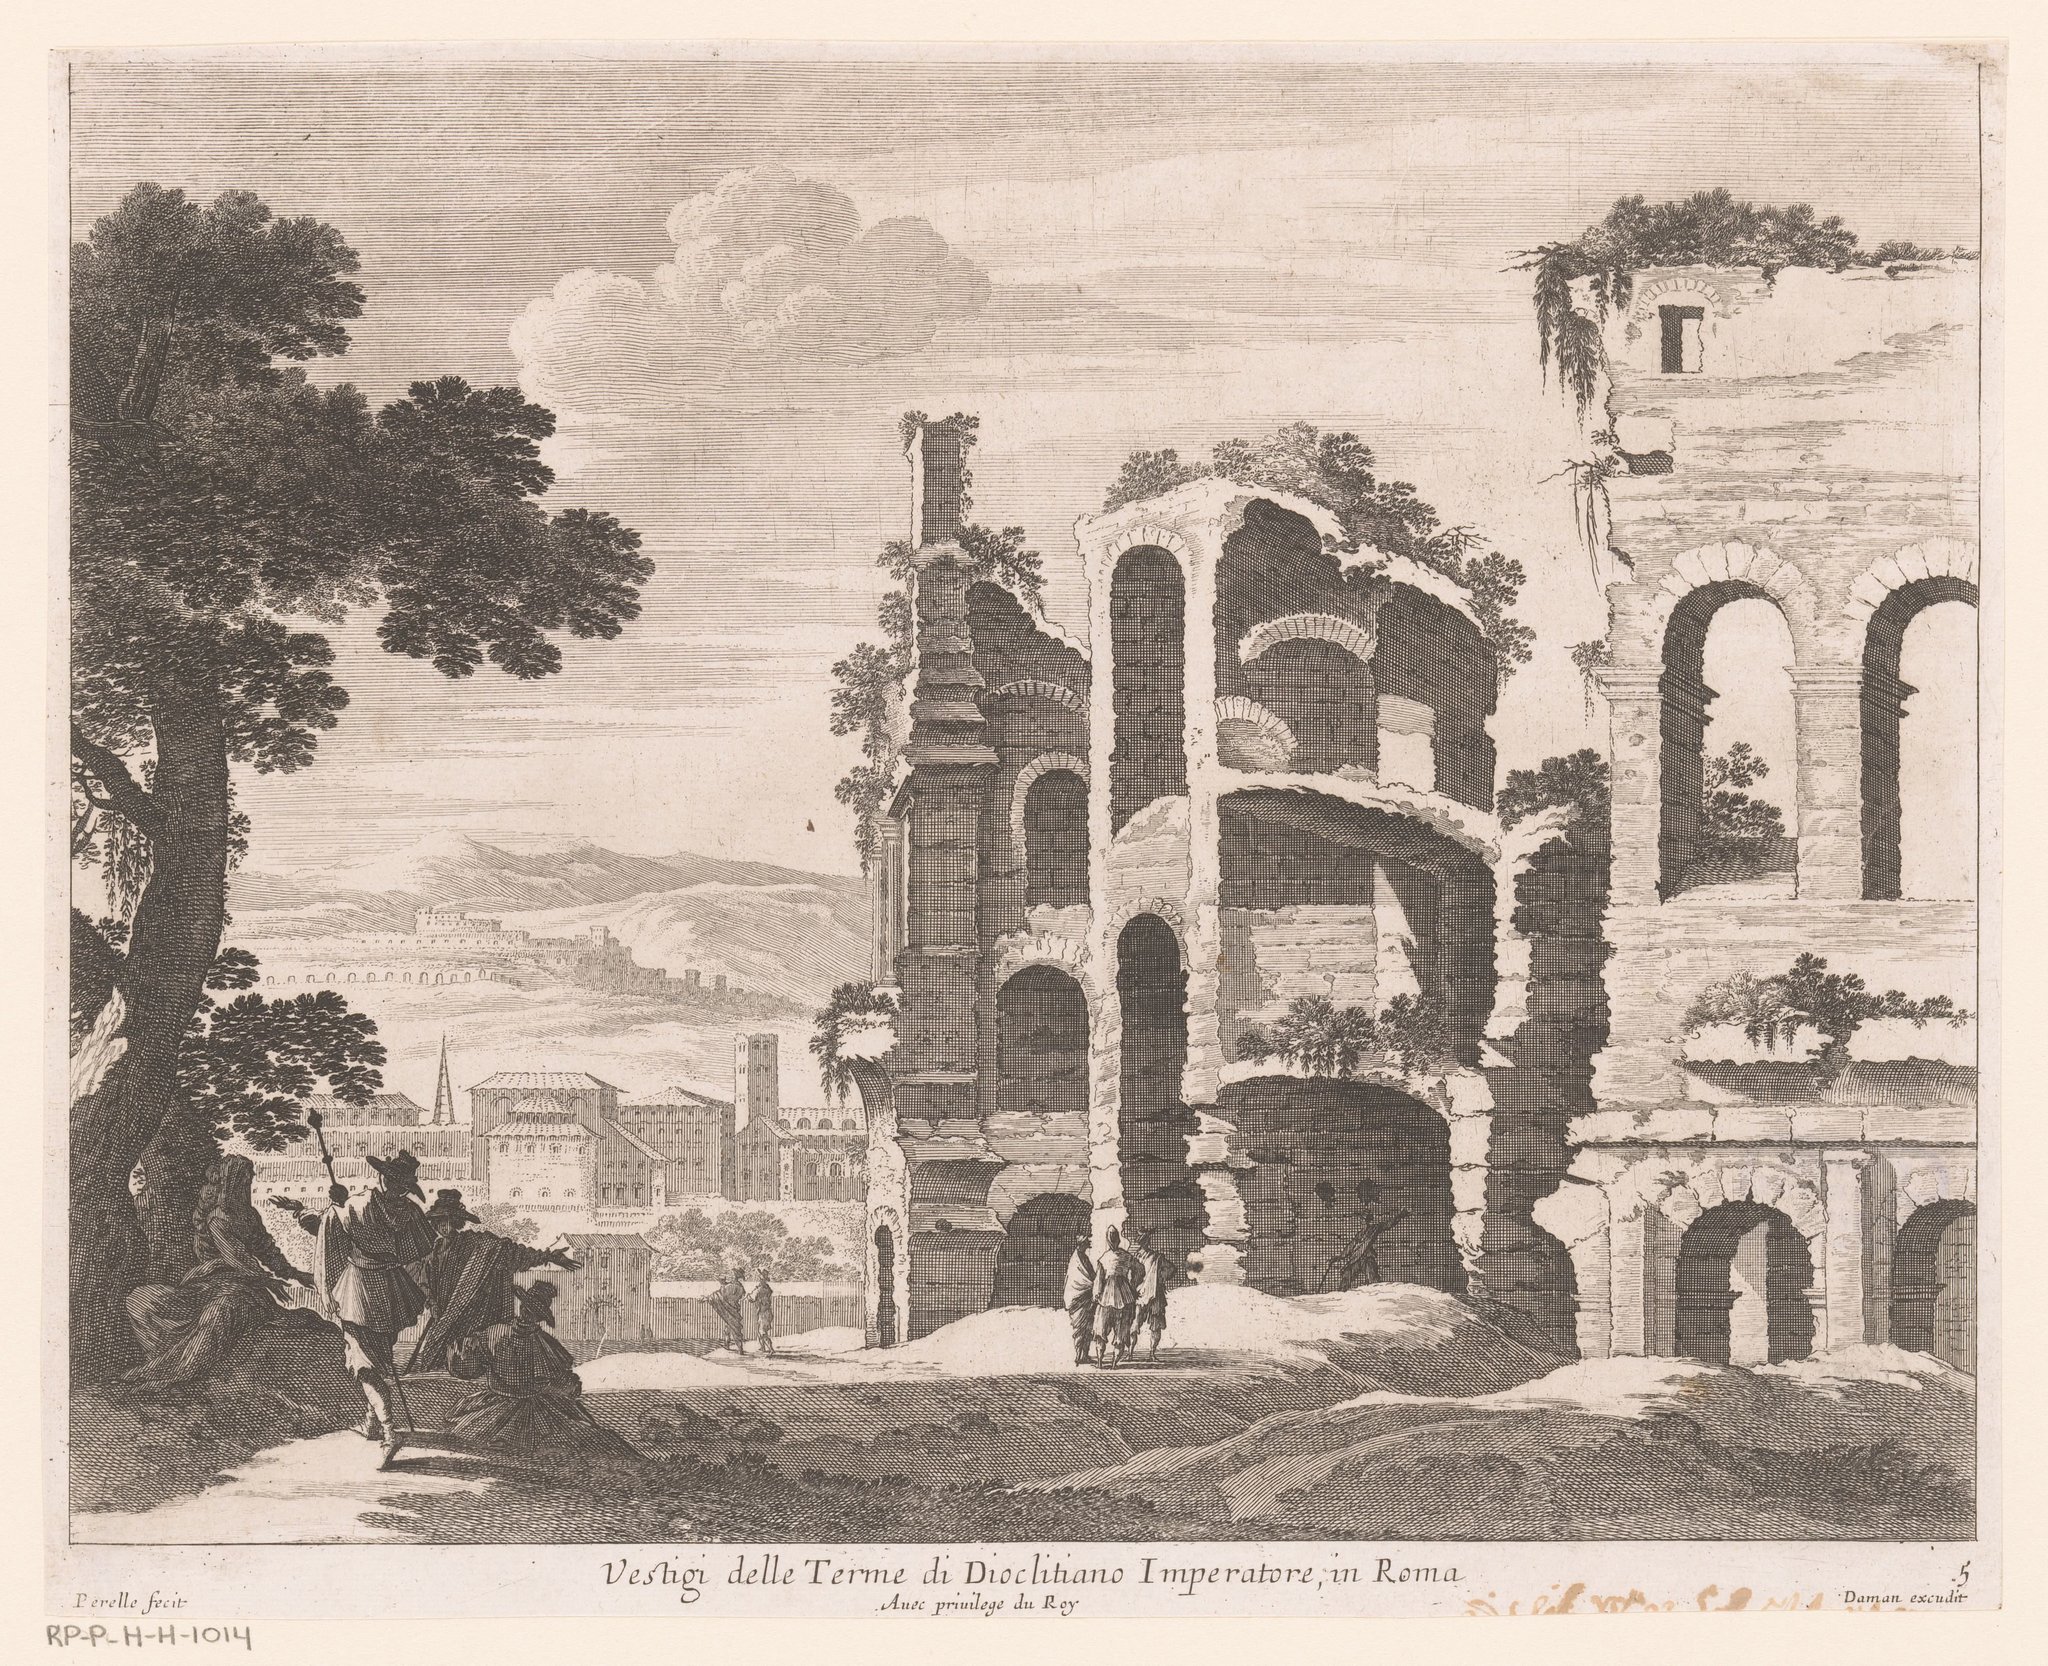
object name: print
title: Vestigi delle Terme di Dioclitiano Imperatore in Roma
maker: daman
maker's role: publisher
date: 1640-1660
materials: paper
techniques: engraving, etching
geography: france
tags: landscape with ruins, public baths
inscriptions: collector's mark: Lugt 10, collector's mark: Lugt 11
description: Prenten met het signatuur 'Perelle' kunnen zowel door vader Gabriel als door zonen Nicolas en Adam gemaakt zijn.